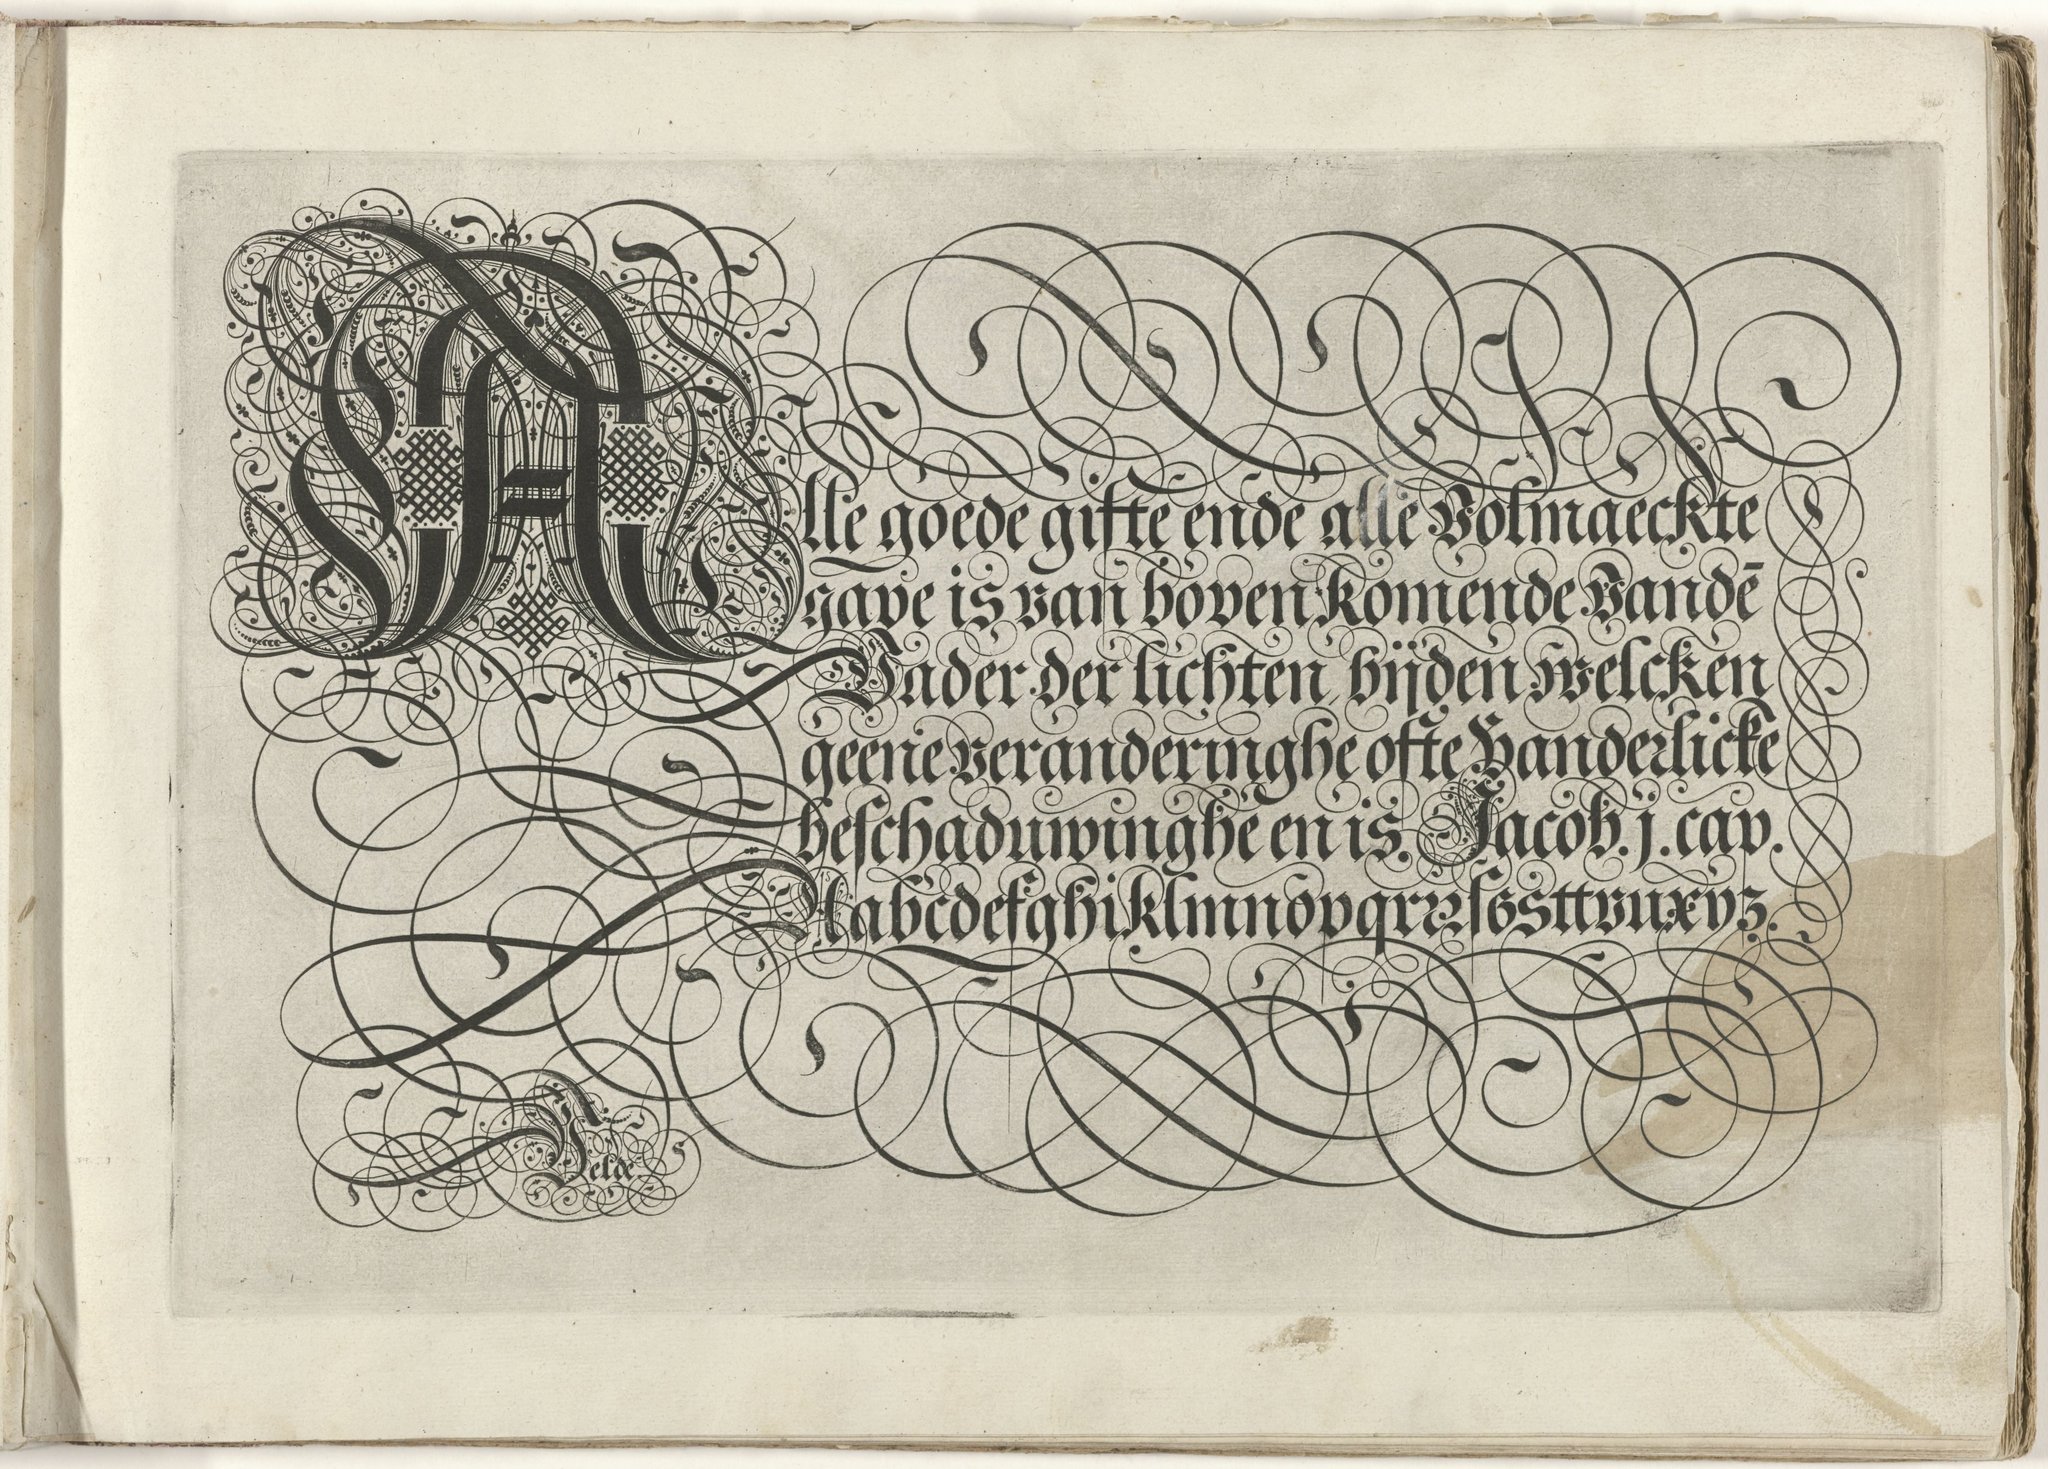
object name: print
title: Spieghel der schrijfkonste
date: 1605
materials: paper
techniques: engraving, intaglio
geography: haarlem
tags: calligraphy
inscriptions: collector's mark: Lugt 2760, collector's mark: Lugt 2228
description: Schrijfvoorbeeld met geornamenteerde initiaal A en zes regels tekst: Alle goede gifte ... (Jak. 1). Het voorbeeld eindigt met een onderkastalfabet in de betreffende hand. De tekst is omlijst door krulwerk. De prent maakt deel uit van een album.